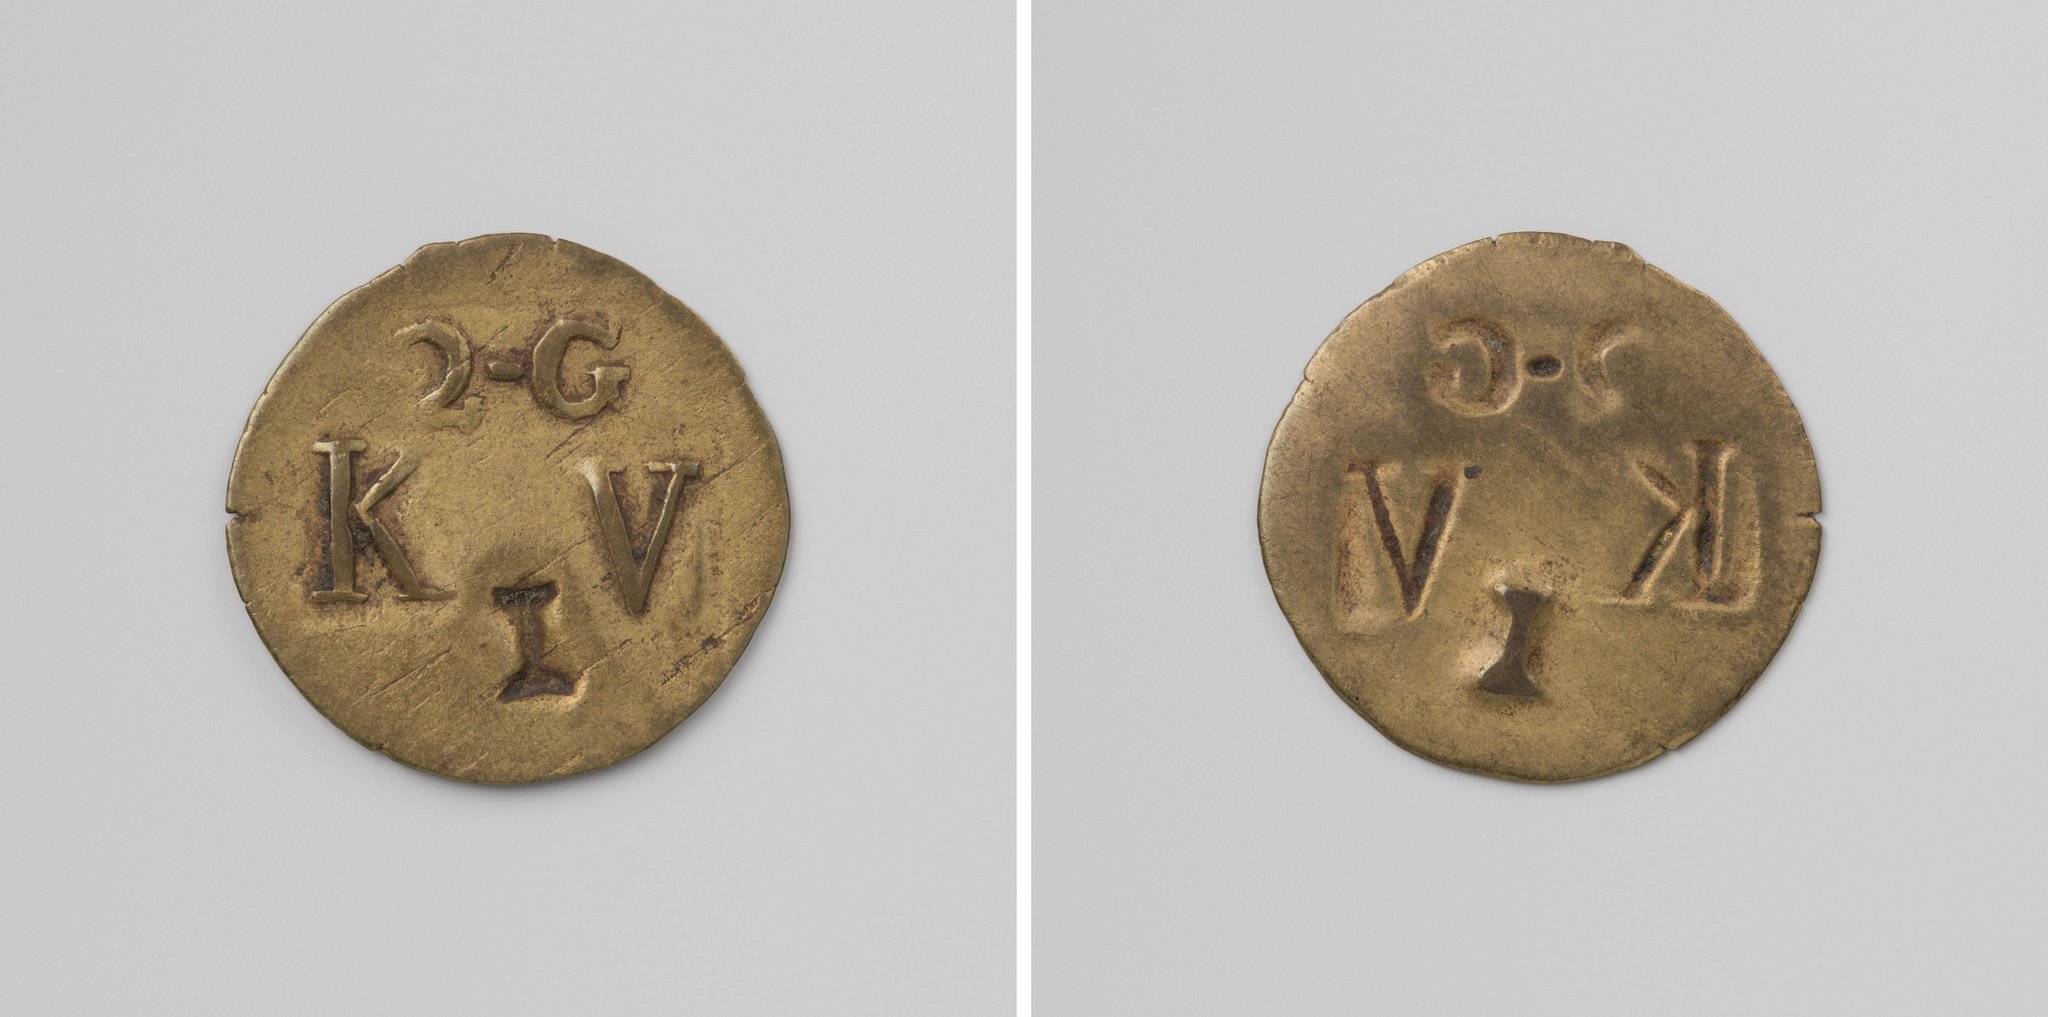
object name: cent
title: Tweede gesticht van de kolonie Veenhuizen, huismunt geslagen op last van de Maatschappij van Weldadigheid ter waarde van 1 cent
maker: Anonymous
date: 1818-1859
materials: brass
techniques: striking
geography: netherlands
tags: maatschappij van weldadigheid, veenhuizen